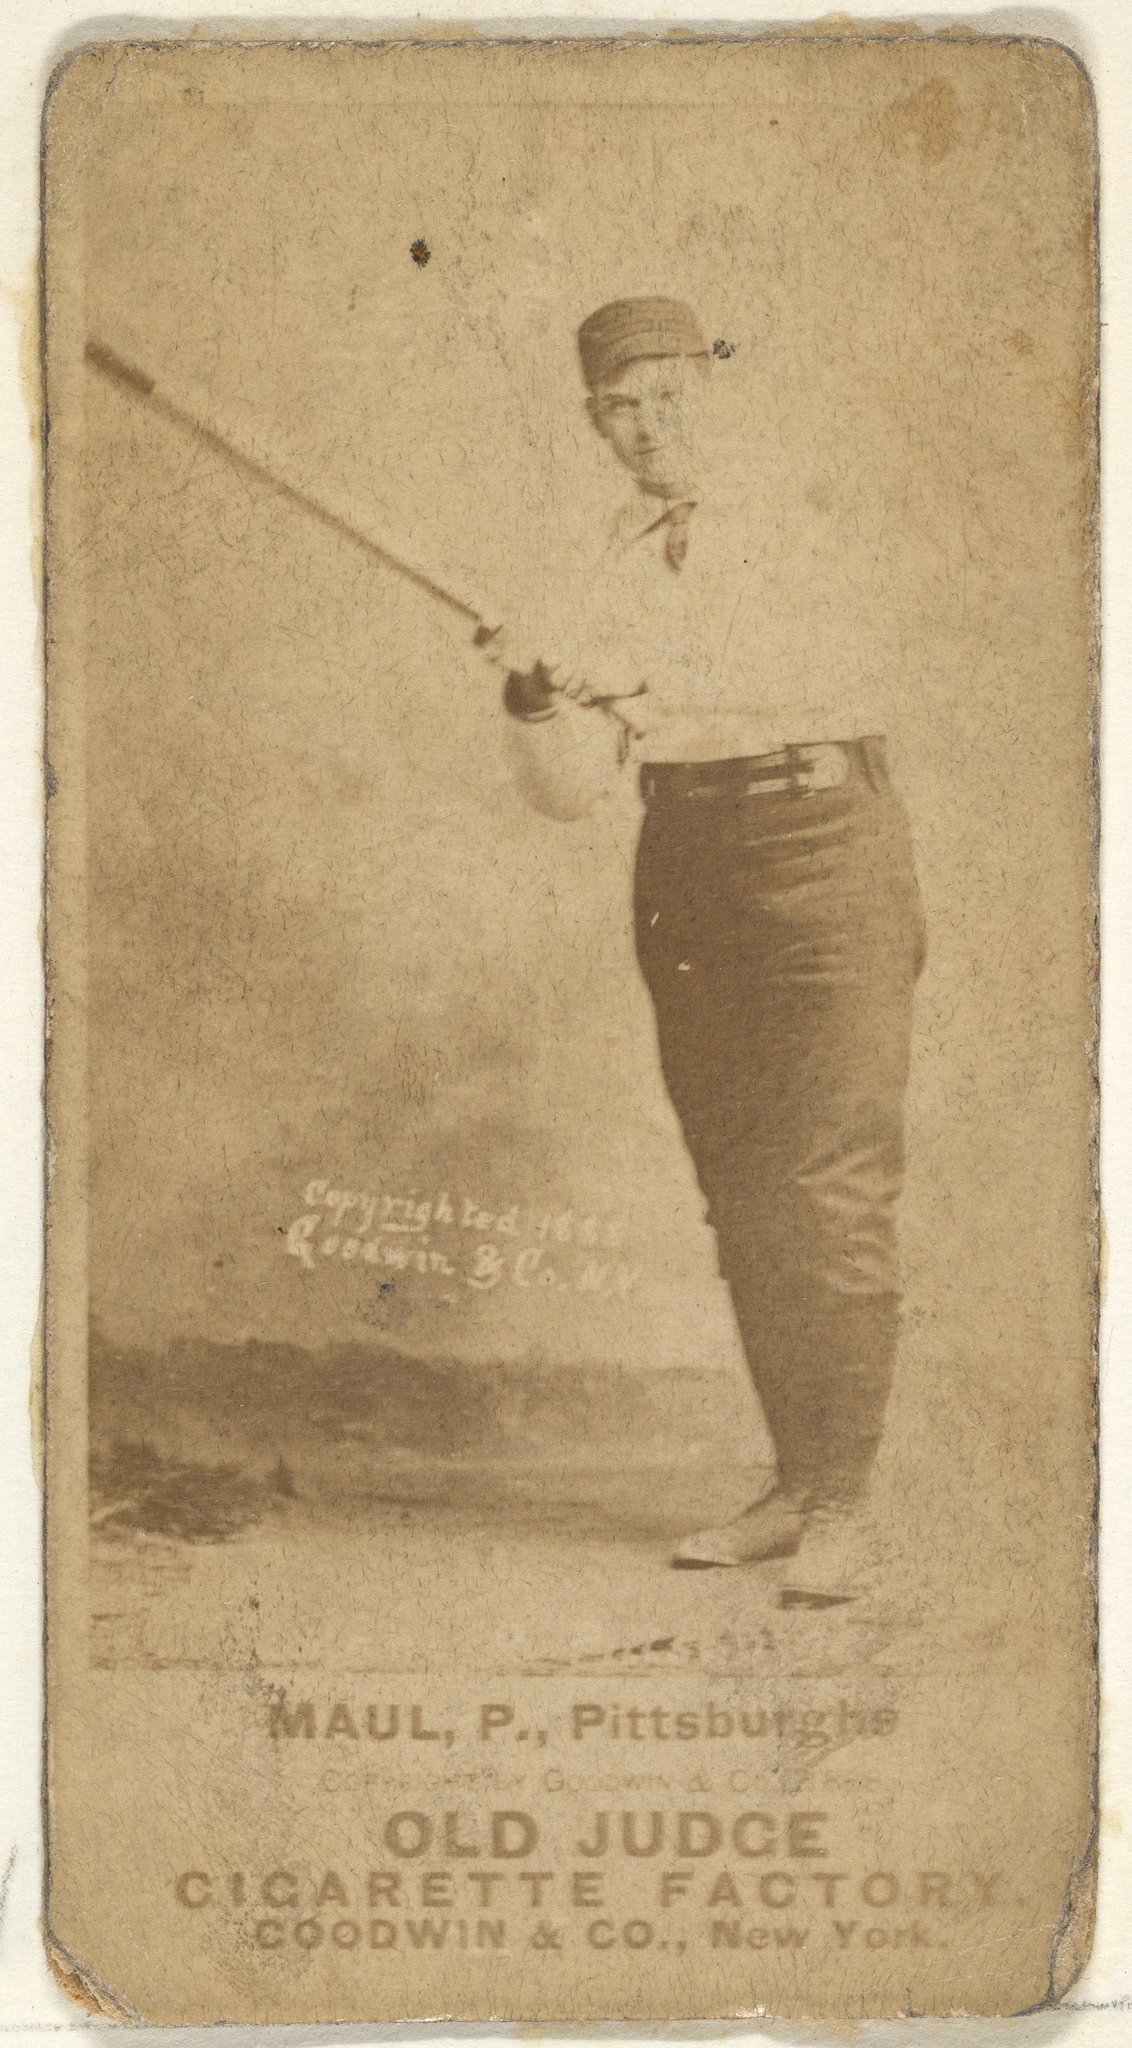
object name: baseball card, photograph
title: Al Maul, Pitcher, Pittsburgh, from the Old Judge series (N172) for Old Judge Cigarettes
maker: goodwin & company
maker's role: publisher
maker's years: 1850-1950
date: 1888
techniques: albumen silver print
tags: men,baseball,athletes